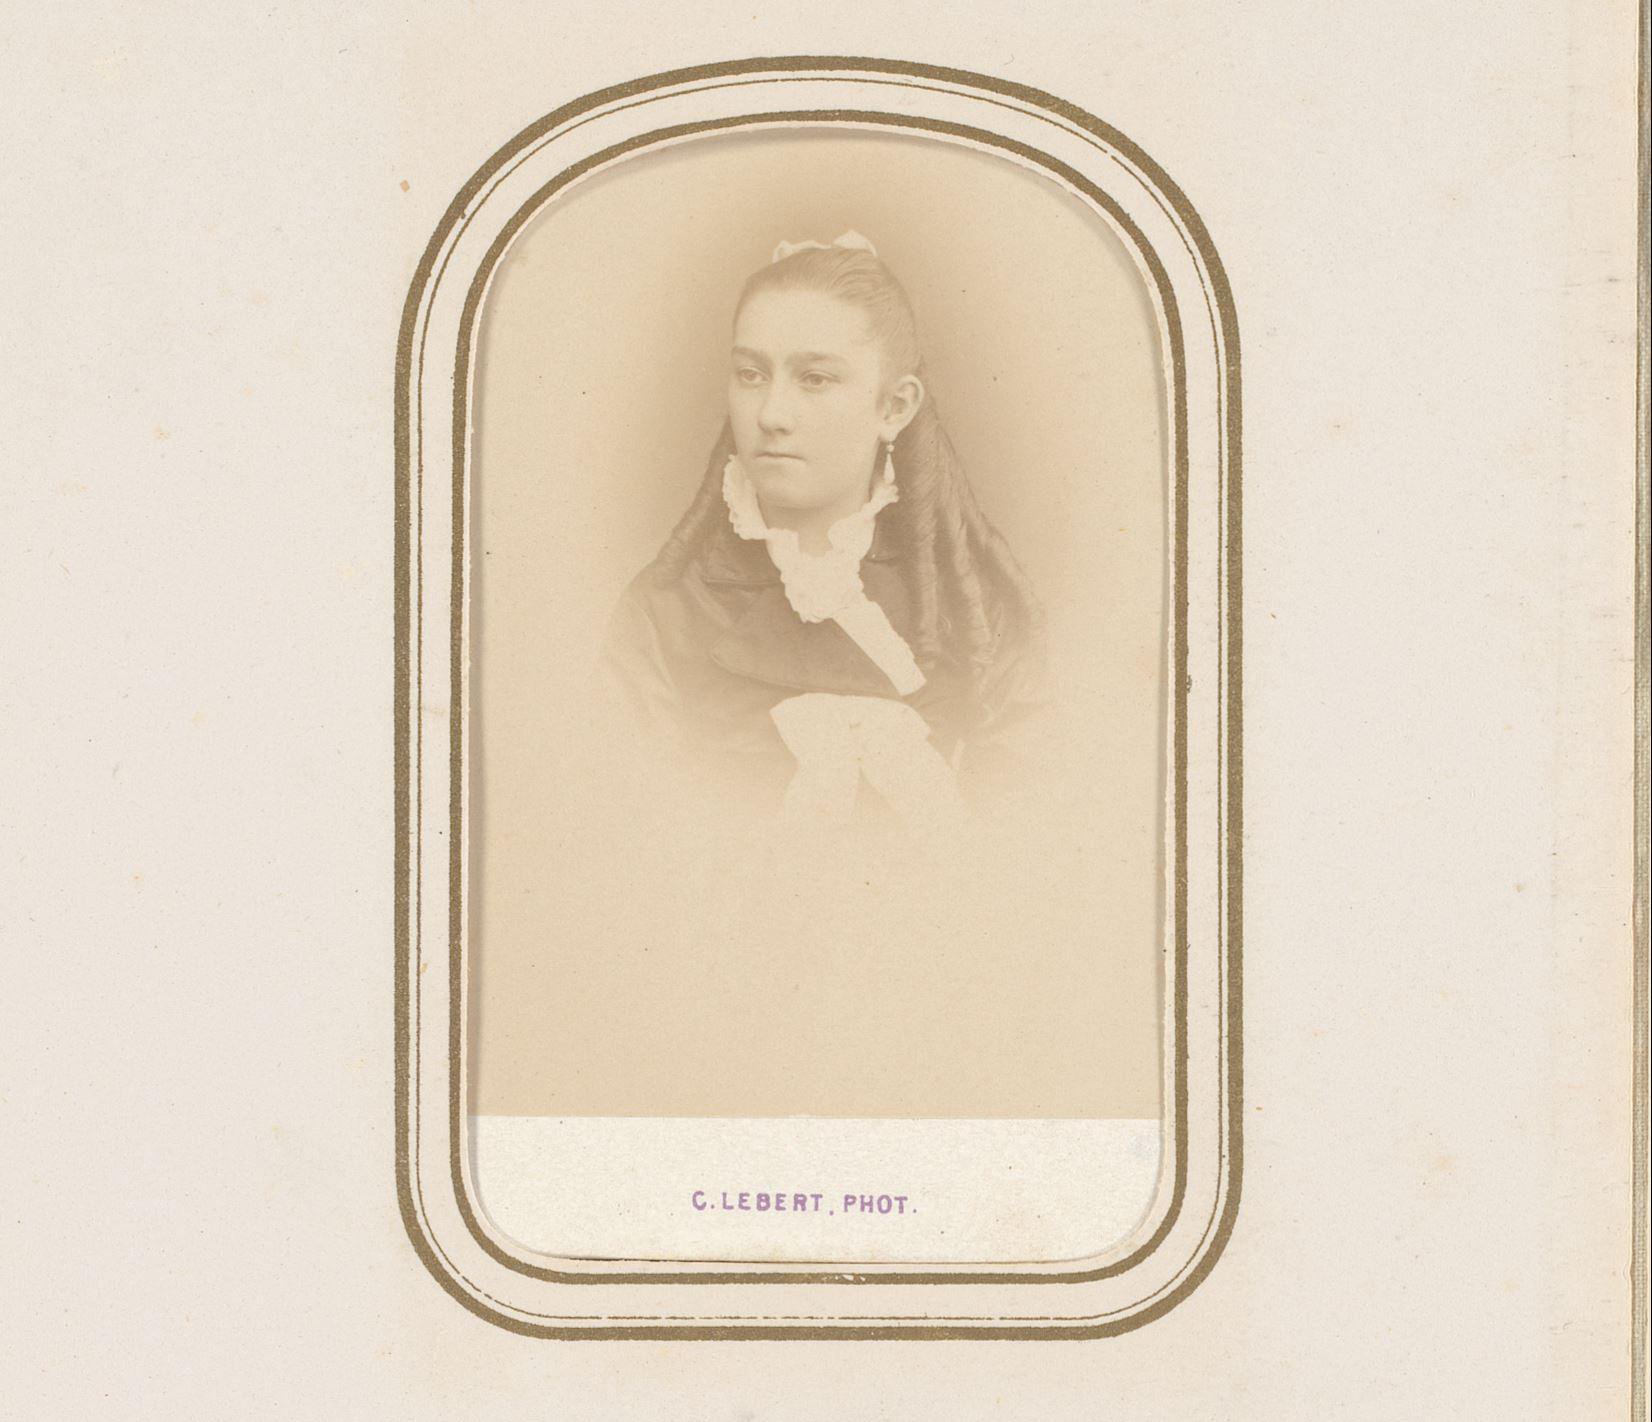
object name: photograph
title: Portret van een jonge vrouw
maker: c. lebert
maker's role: fotograaf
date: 1850-1890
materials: cardboard, photographic support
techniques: albumen print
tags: adolescent, young woman, maiden, historical persons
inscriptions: inscription: ‘C. Lebert/ Peintre Phottographe/ 21. Rue de Sevres/ Paris’